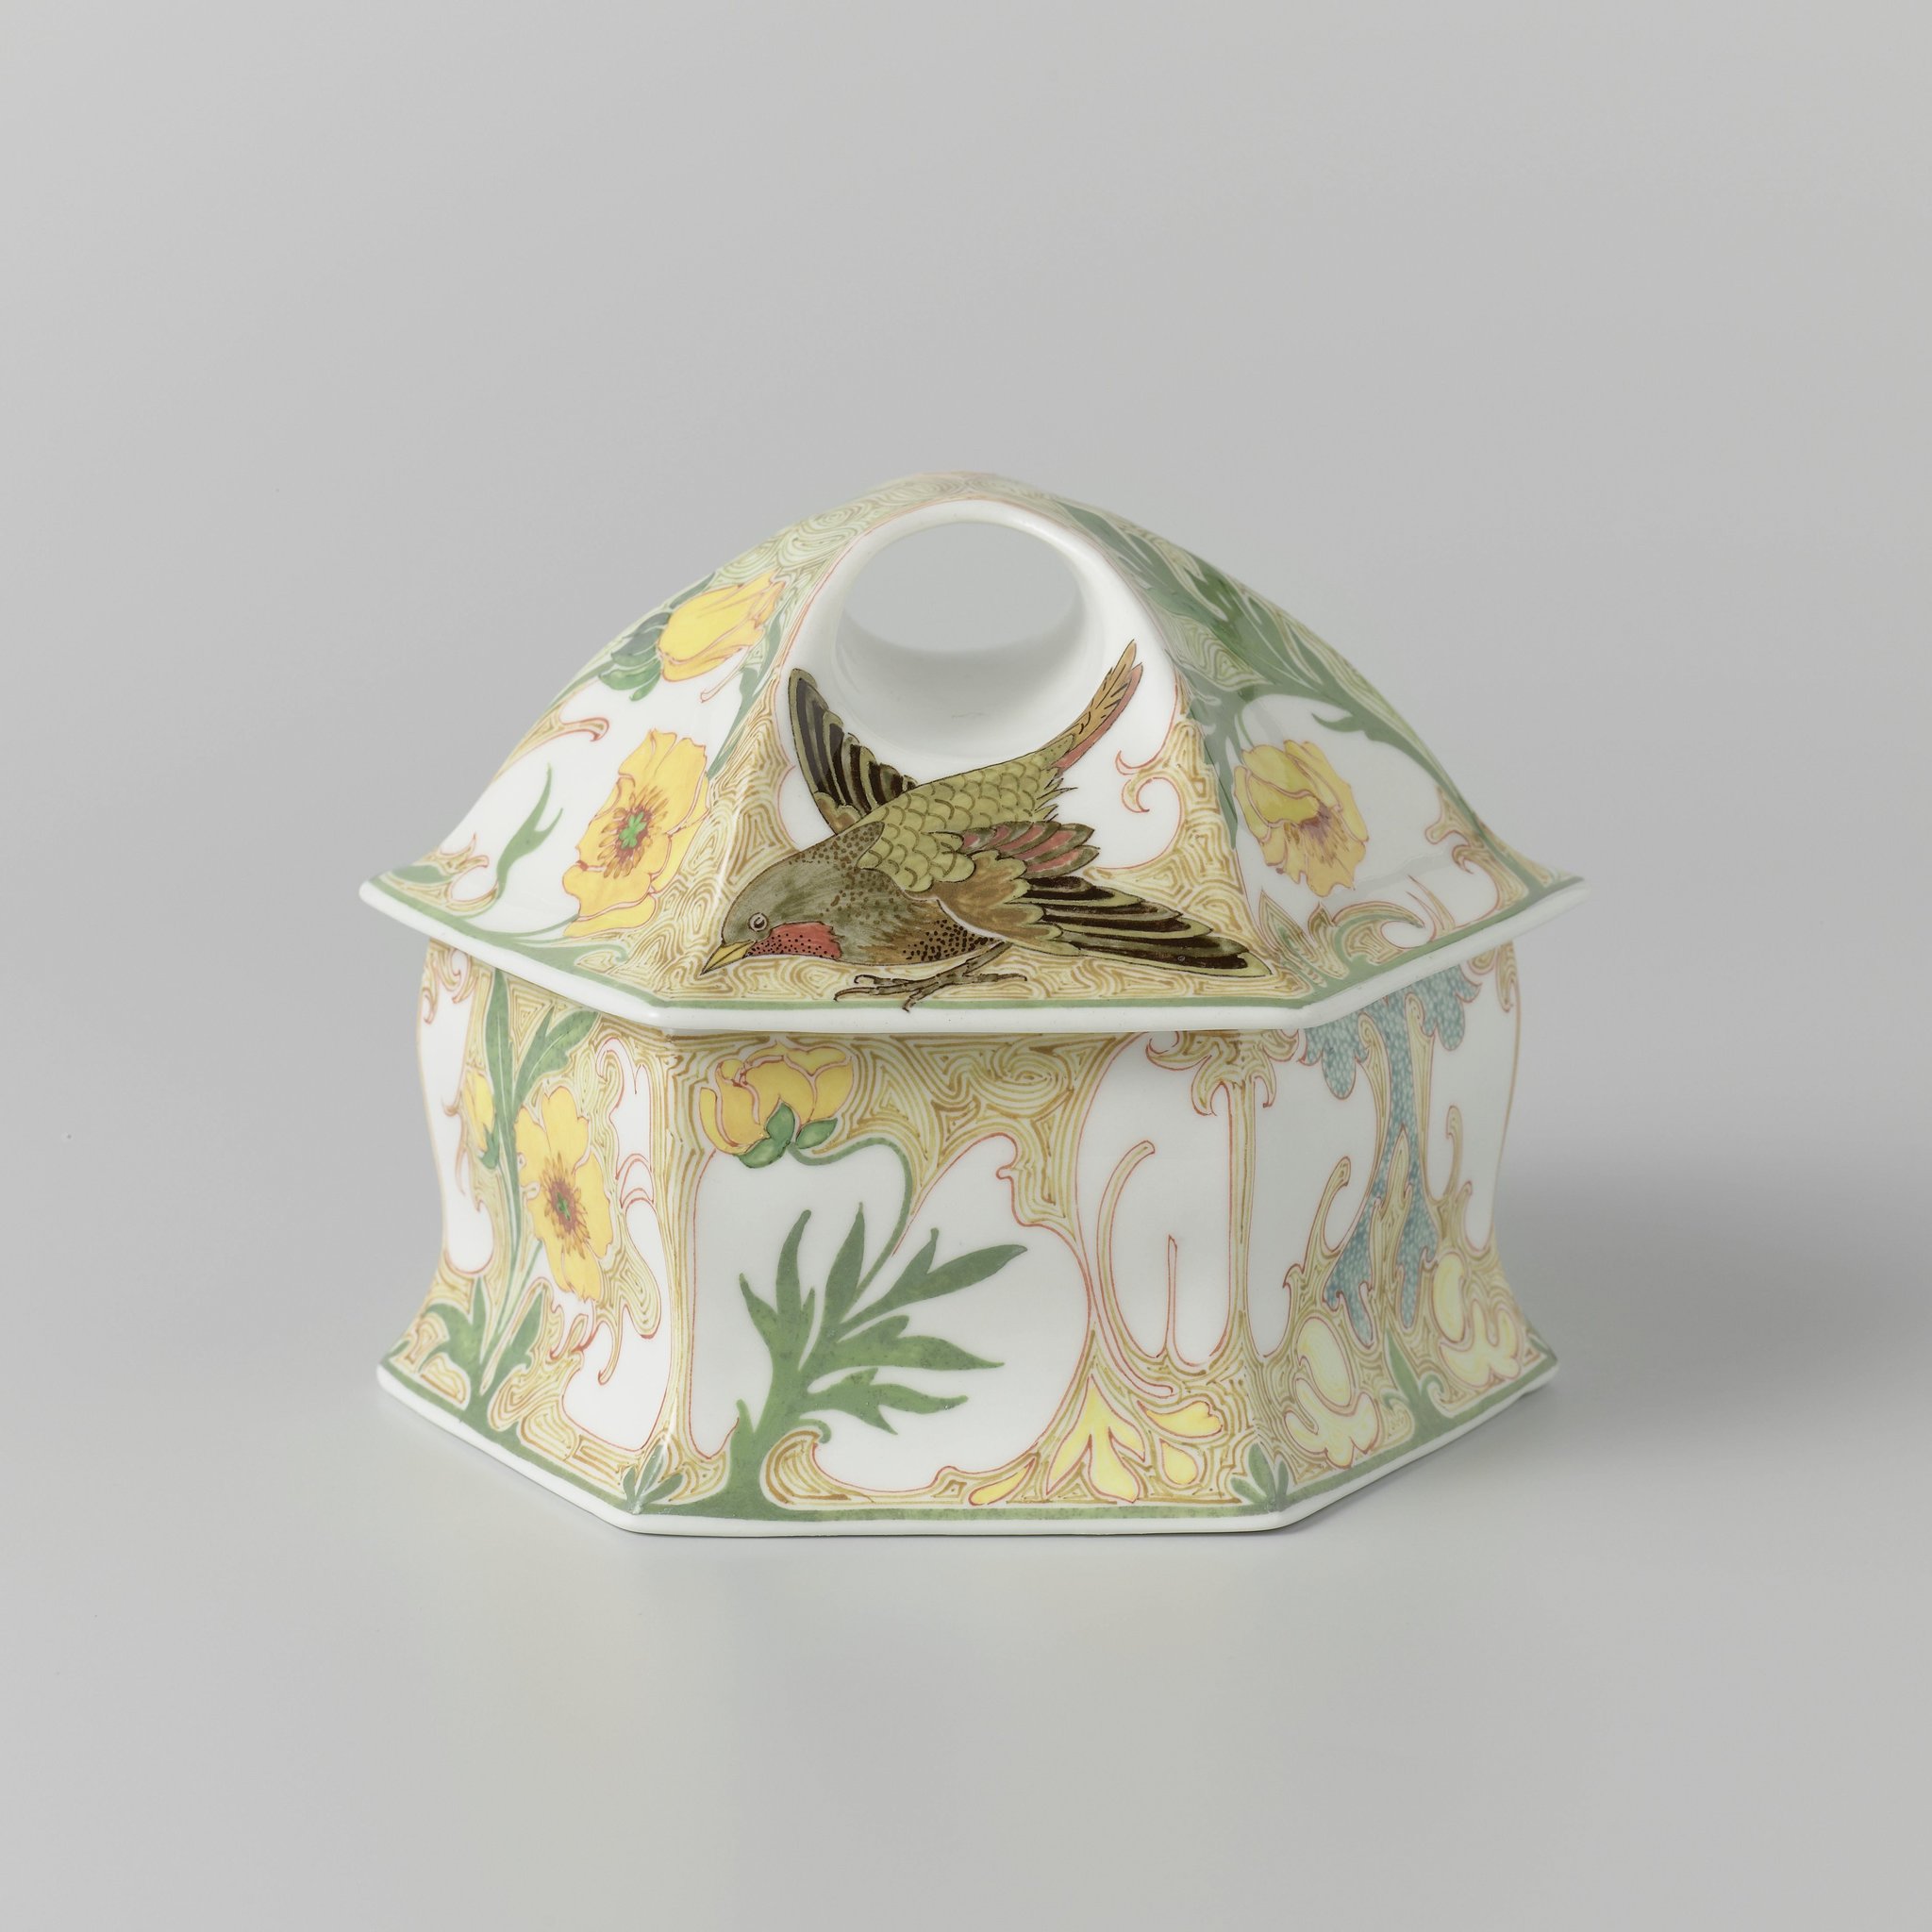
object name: sweetmeat stand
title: Bonbonnière beschilderd met bloemen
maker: sam schellink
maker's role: ceramicist, draughtsman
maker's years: 1876-1958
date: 1914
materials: porcelain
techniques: painted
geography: the hague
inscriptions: mark: ‘kroon // Rozenburg // ooievaar // den Haag ; jaarteken ; werkordernummer 377 ; schildersmerk SS. (in elkaar)’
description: Bonbonnière met deksel (B) van porselein, zeshoekig, polychroom beschilderd in de kleuren groen, geel, rood en zwart met bloemmotieven.